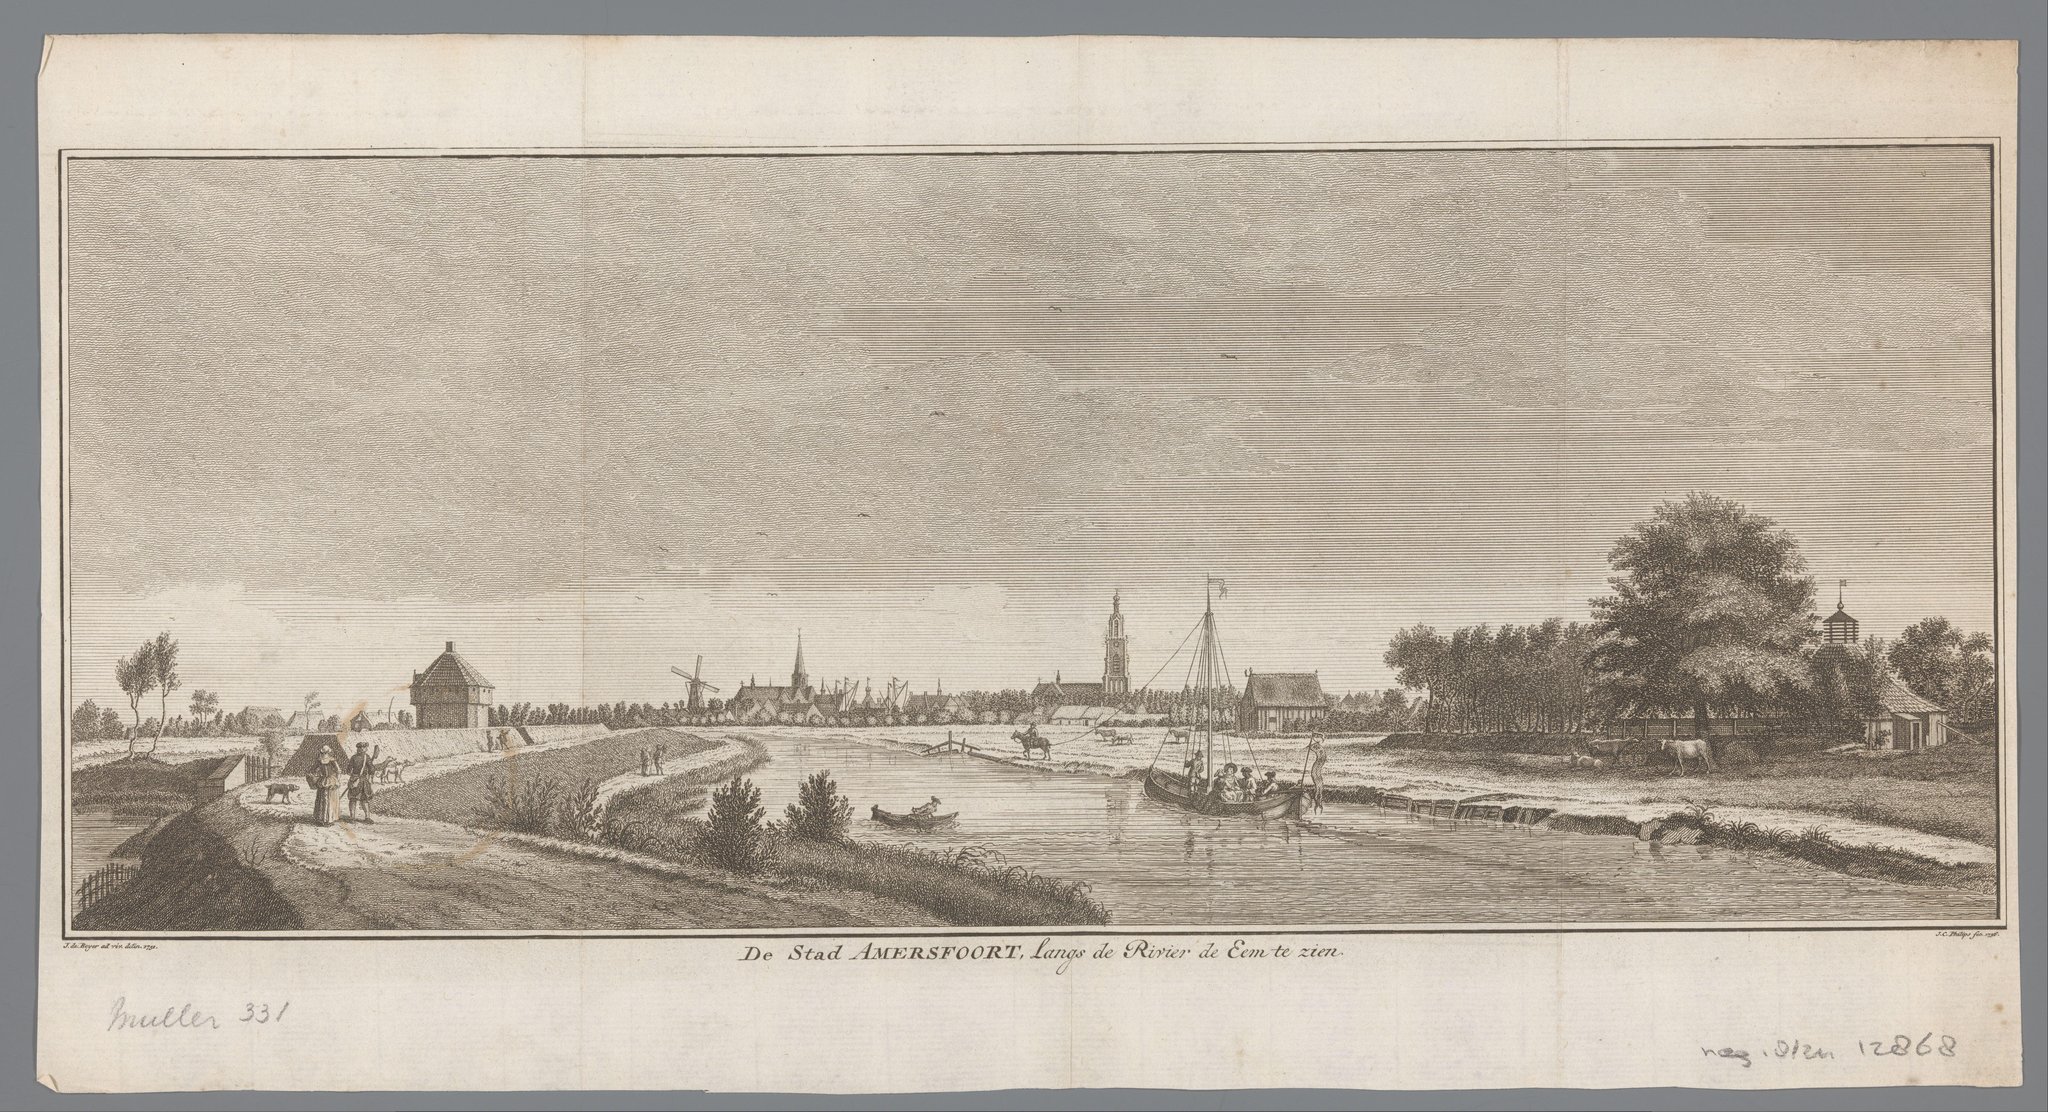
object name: print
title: De stad Amersfoort, langs de rivier de Eem te zien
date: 1756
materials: paper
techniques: engraving, etching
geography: amsterdam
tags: sailing-ship, sailing-boat, church (exterior), windmill, boat propelled by man or animal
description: Prent uit: Tegenwoordige staat der Vereenigde Nederlanden, twaalfde deel (...) provincie van Utrecht. Amsterdam: Isaak Tirion, dl. 12 (1756), voor p. 1.